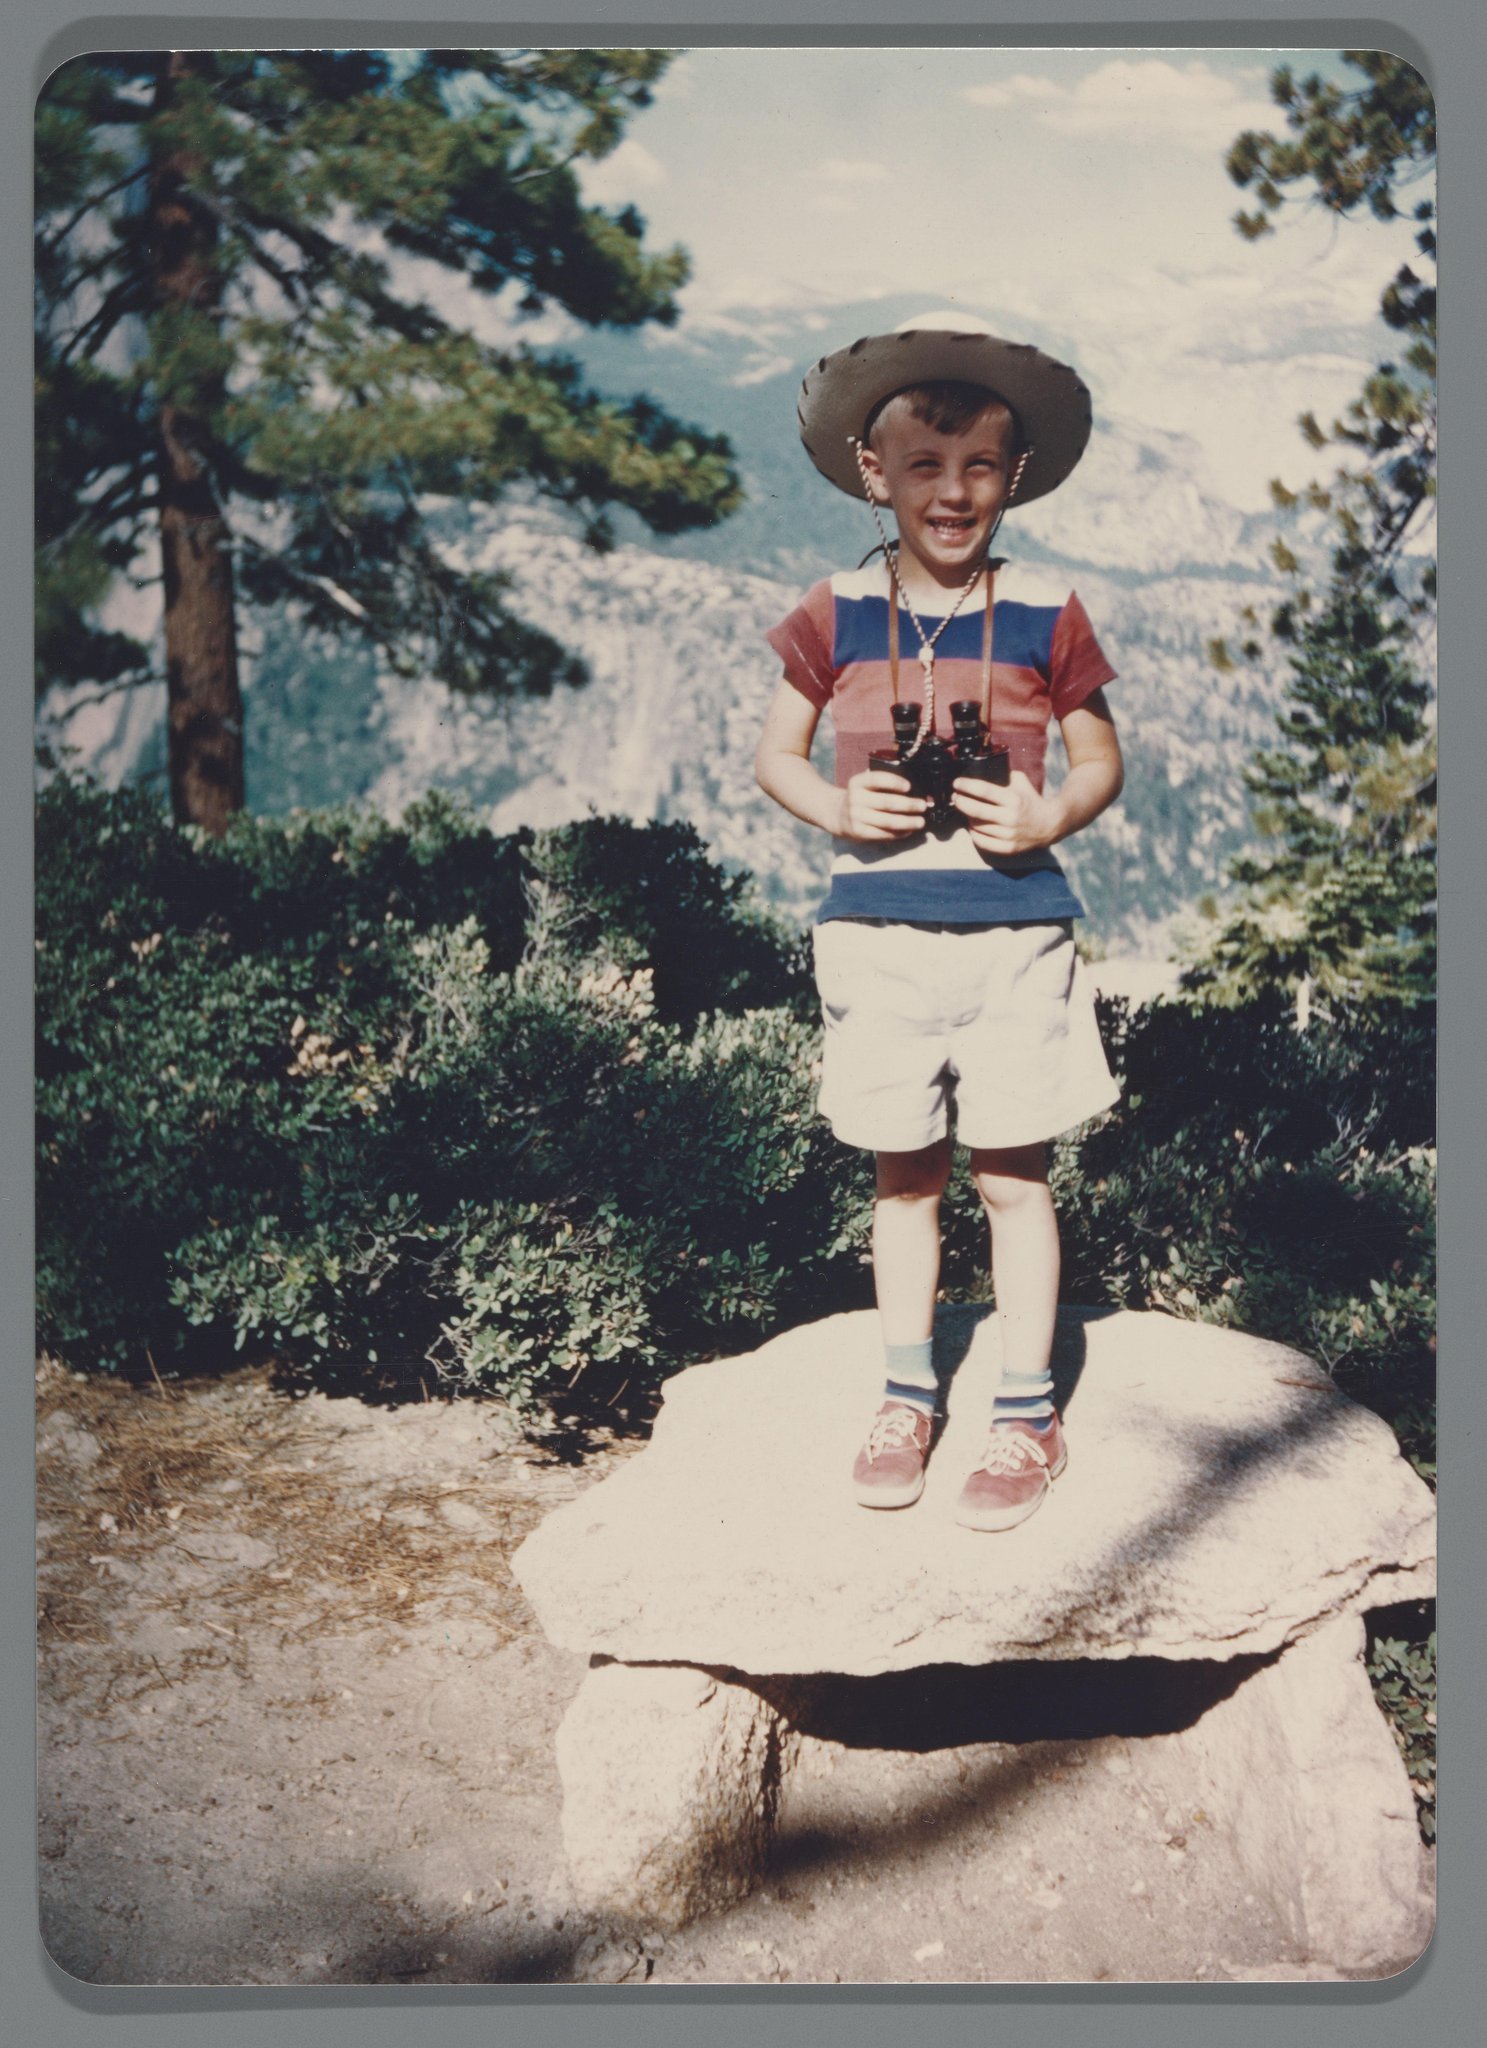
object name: photograph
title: Portret van Mel Kraemer Jr, Yosemite Valley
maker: Anonymous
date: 1952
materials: photographic support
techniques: color photography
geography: yosemite valley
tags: yosemite valley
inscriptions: inscription: ‘"This is a / KODACHROME ENLARGEMENT / made by / EASTMAN KODAK COMPANY / T.M. Regis U. S. Pat Off / AUG 26 52 12"’, title: ‘"Mel Kraemer Jr / July 23 at yosemite / 1952"’